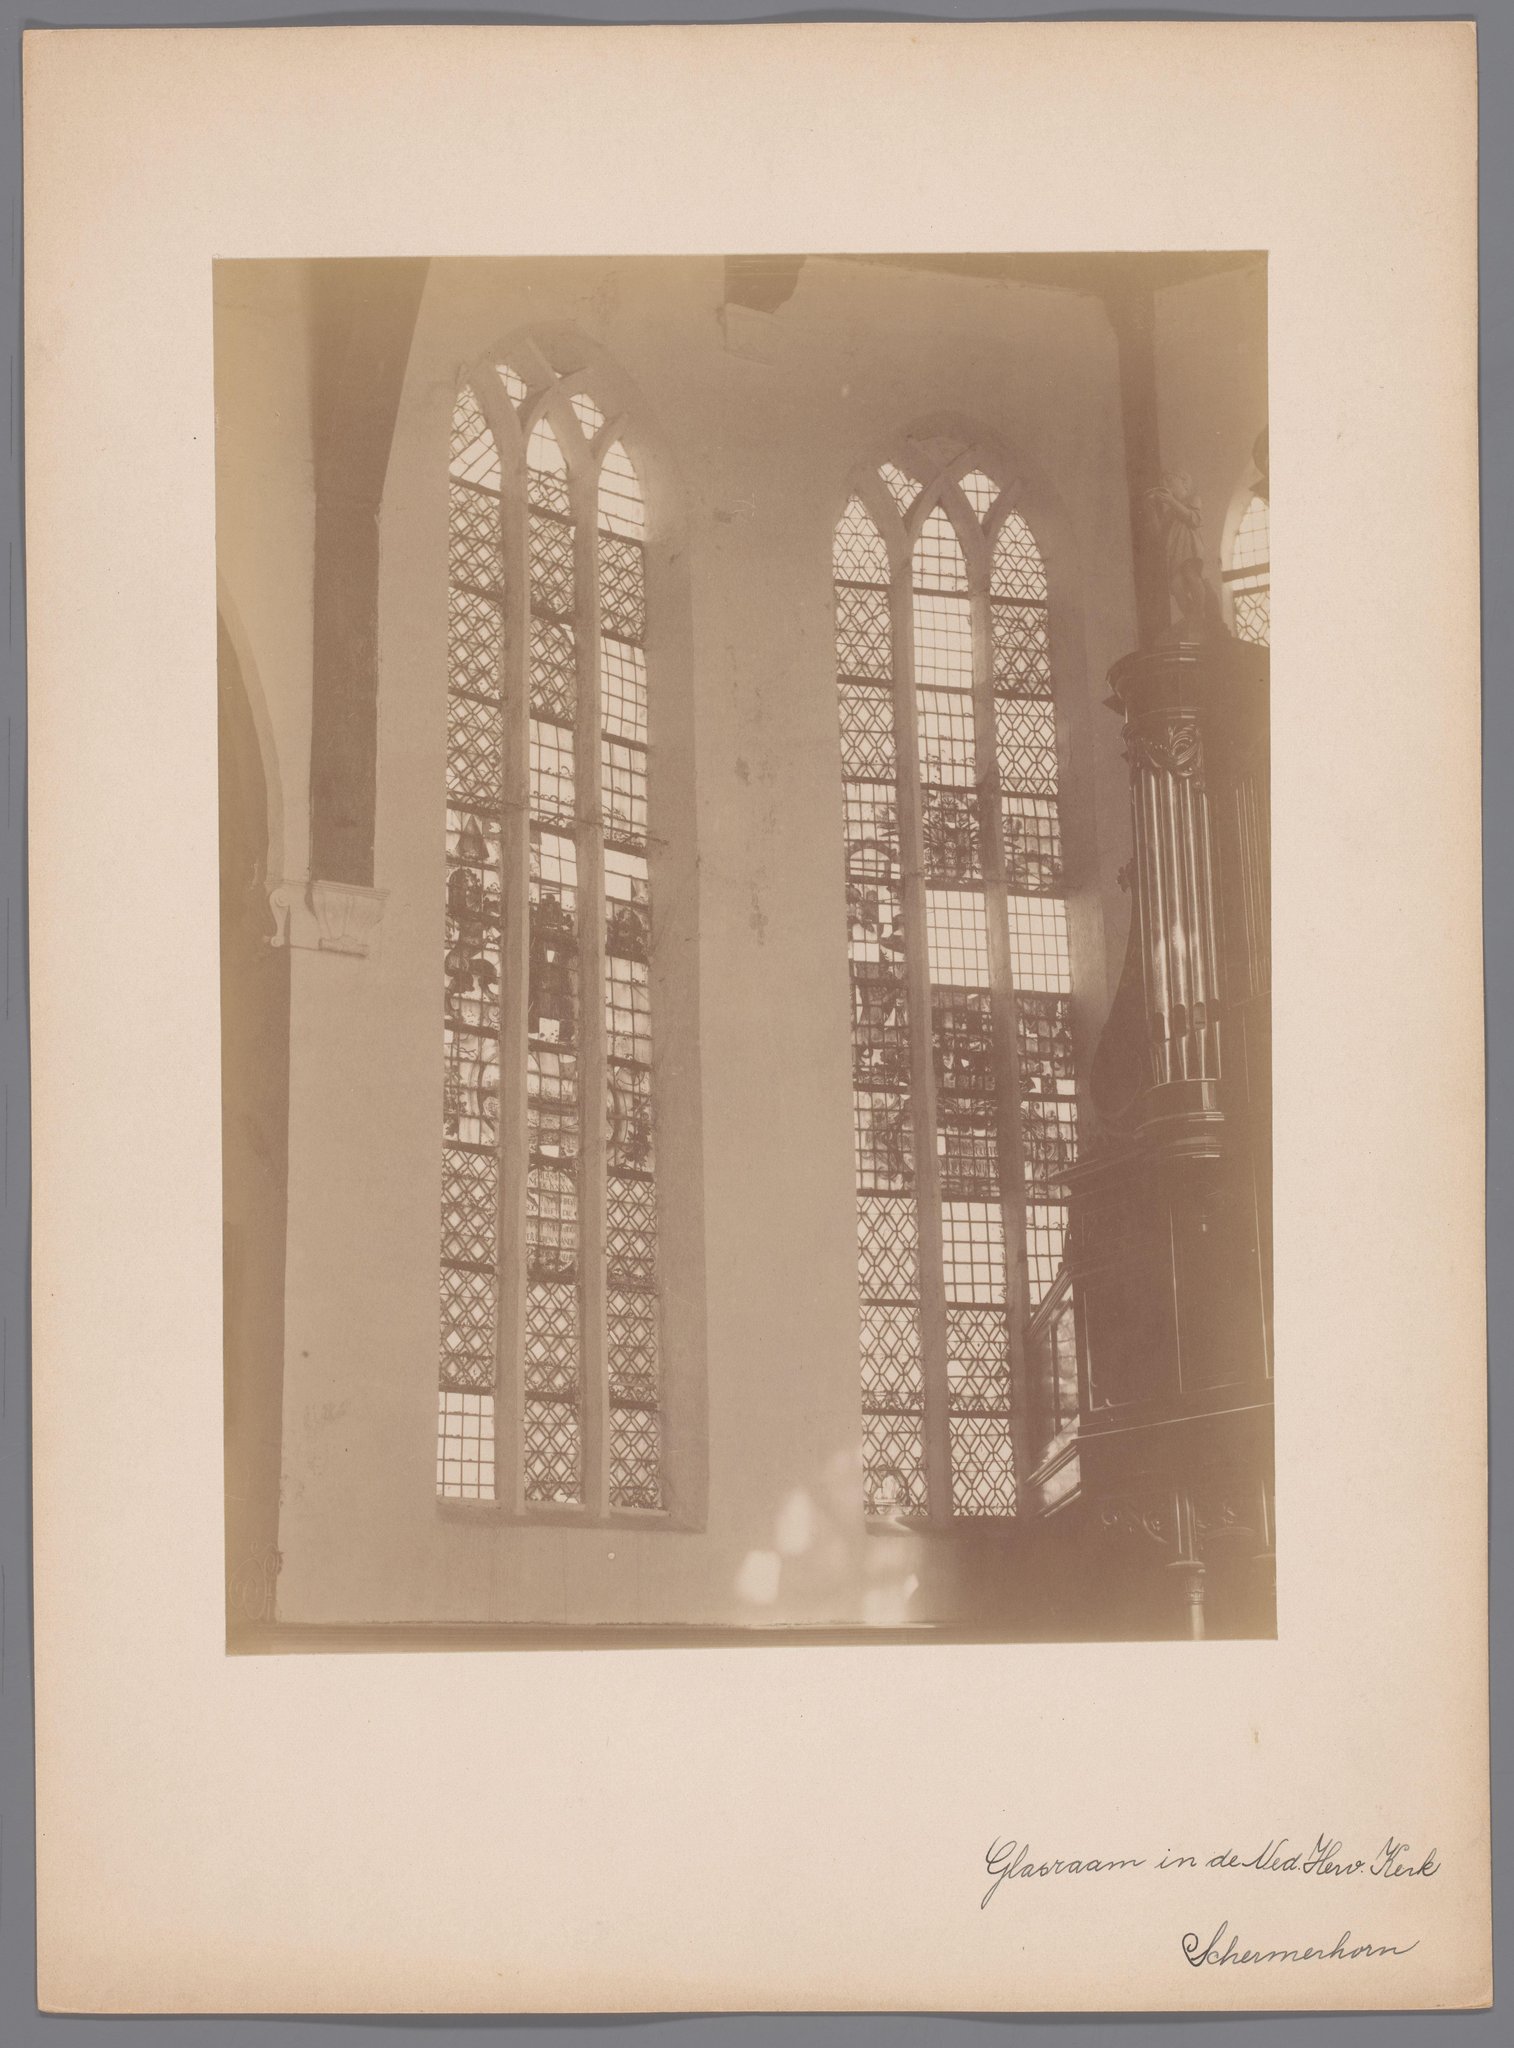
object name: photograph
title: Geschilderd raam in de Grote Kerk te Schermerhorn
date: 1890-1910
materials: cardboard, photographic support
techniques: albumen print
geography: schermerhorn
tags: church-window, e.g. rose-window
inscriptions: annotation: ‘Glasraam in de Ned. Herv. Kerk/ Schermerhorn’, annotation: ‘Schermerhorn/ glasraam in de Ned Herv. Kerk’